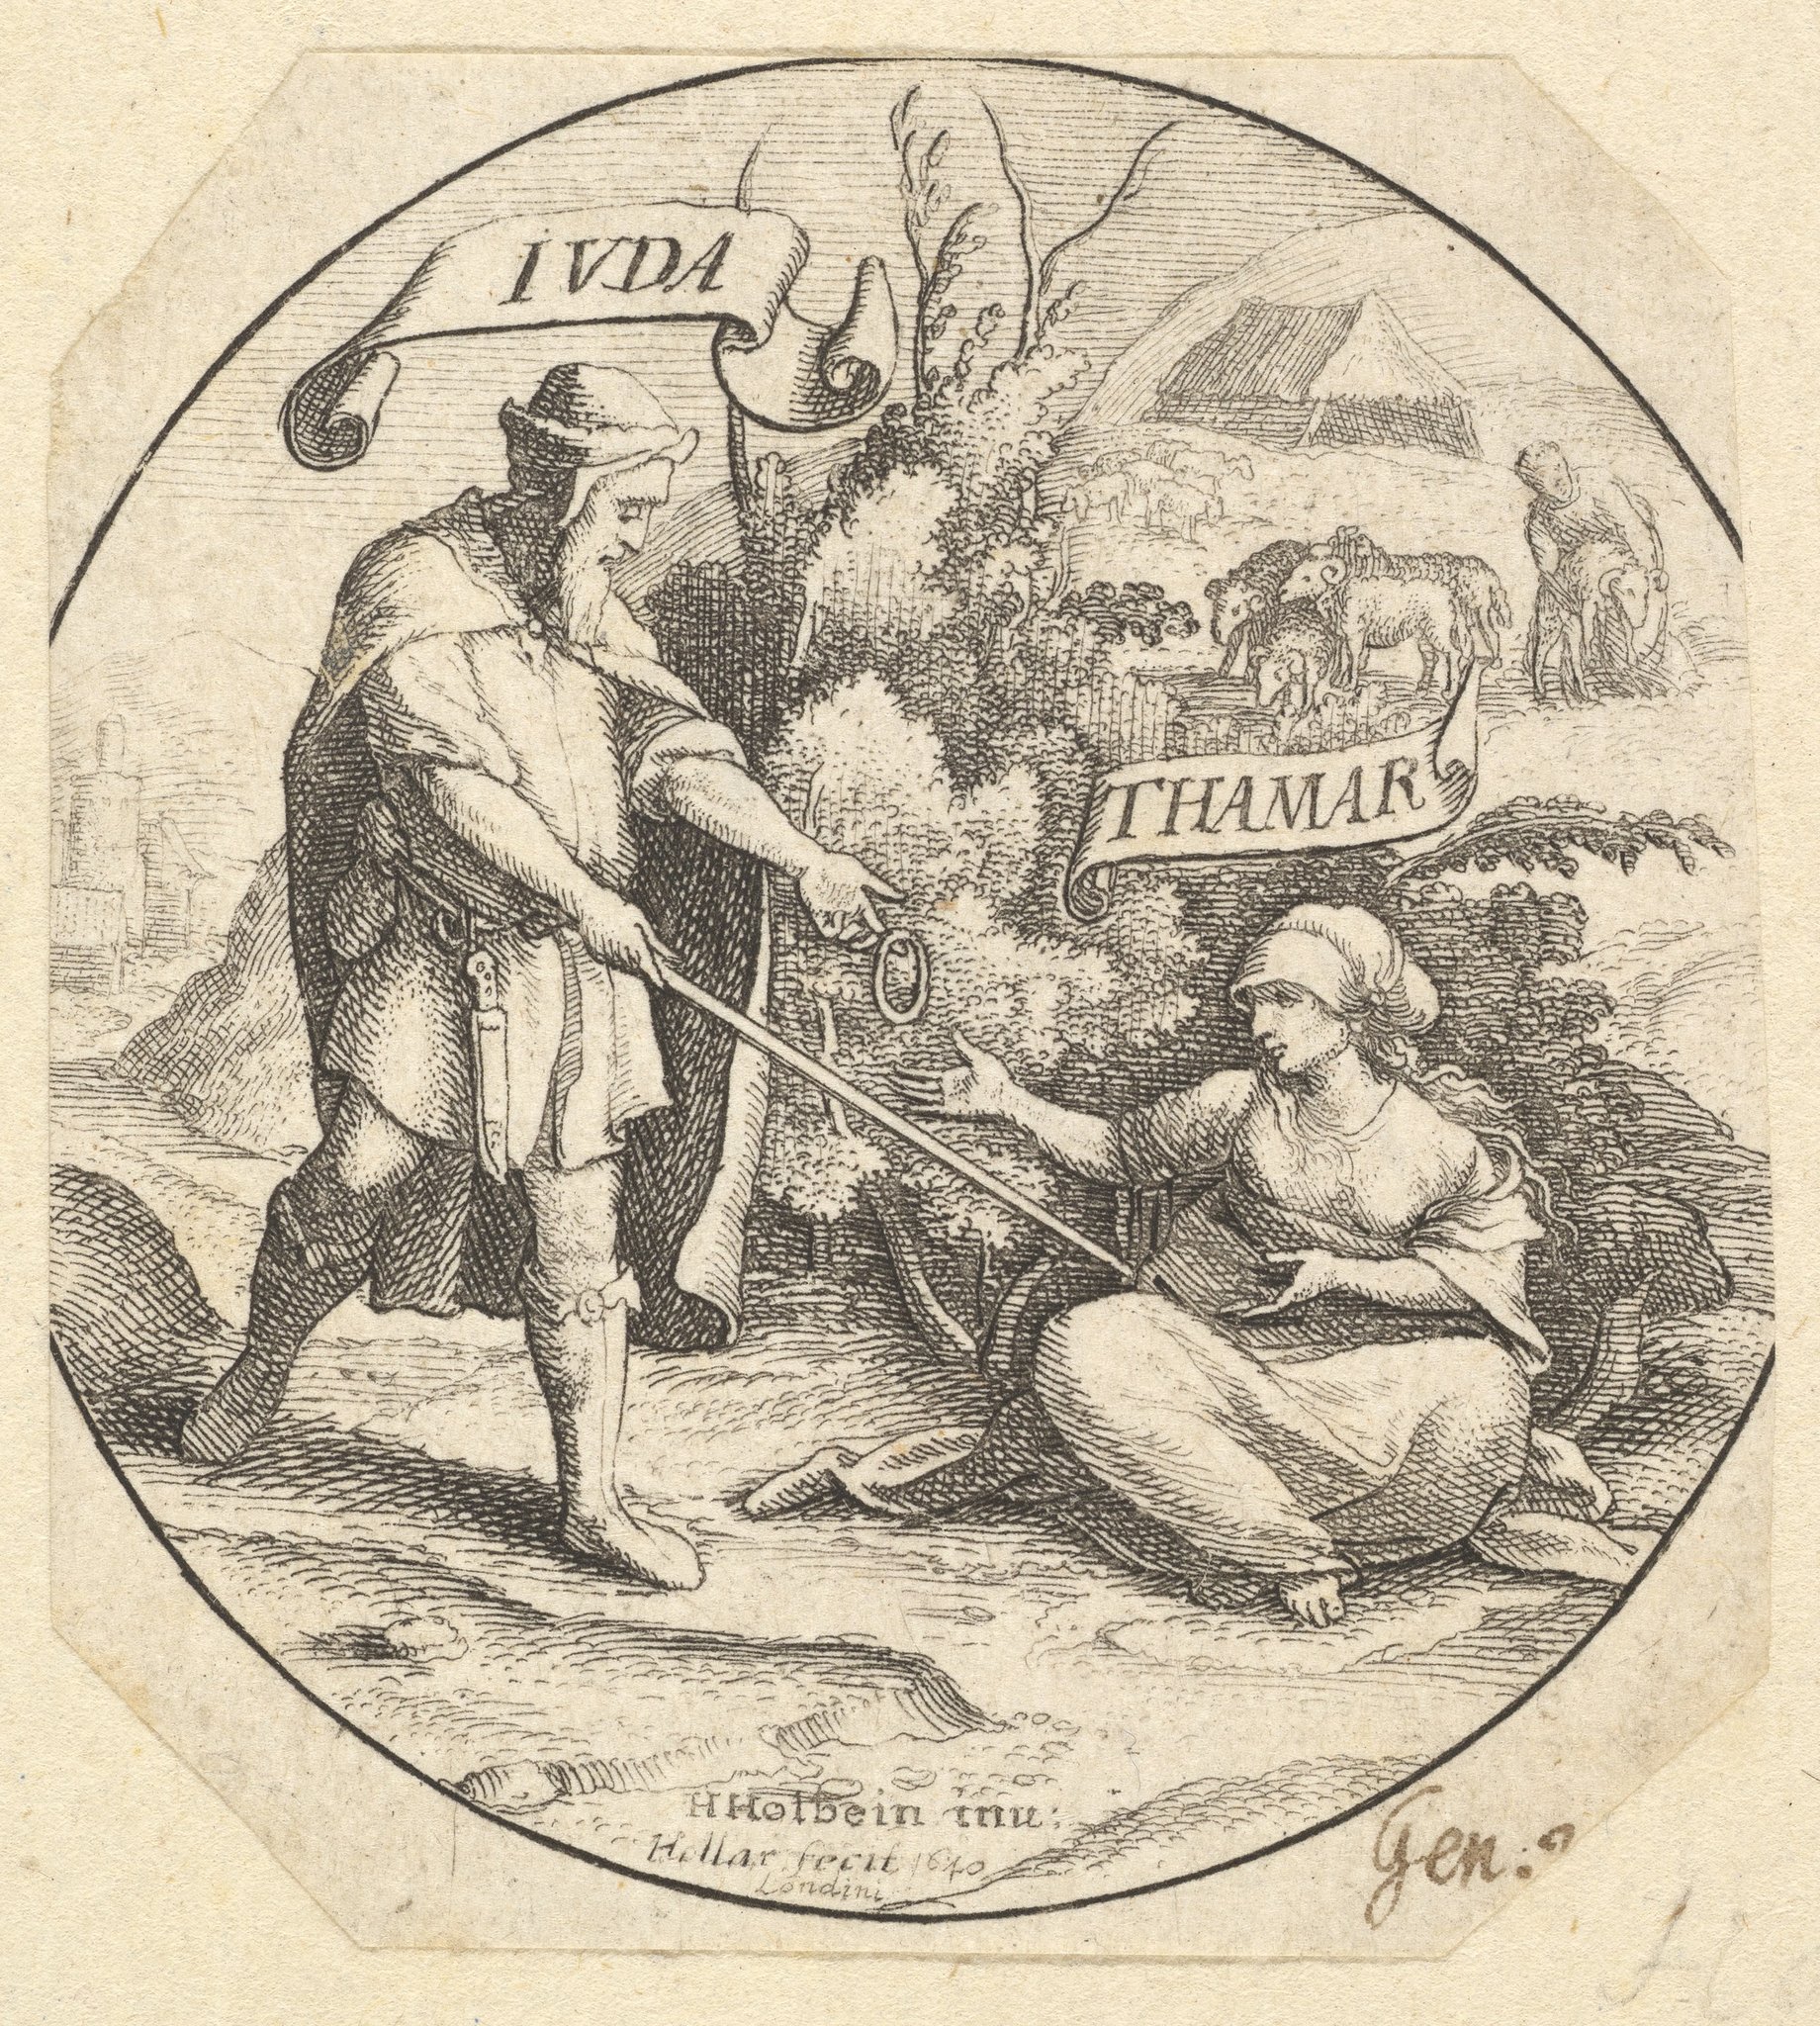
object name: print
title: Judah and Tamar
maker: wenceslaus hollar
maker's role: artist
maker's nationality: bohemian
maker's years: 1607-1677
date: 1640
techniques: etching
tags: rings,men,women